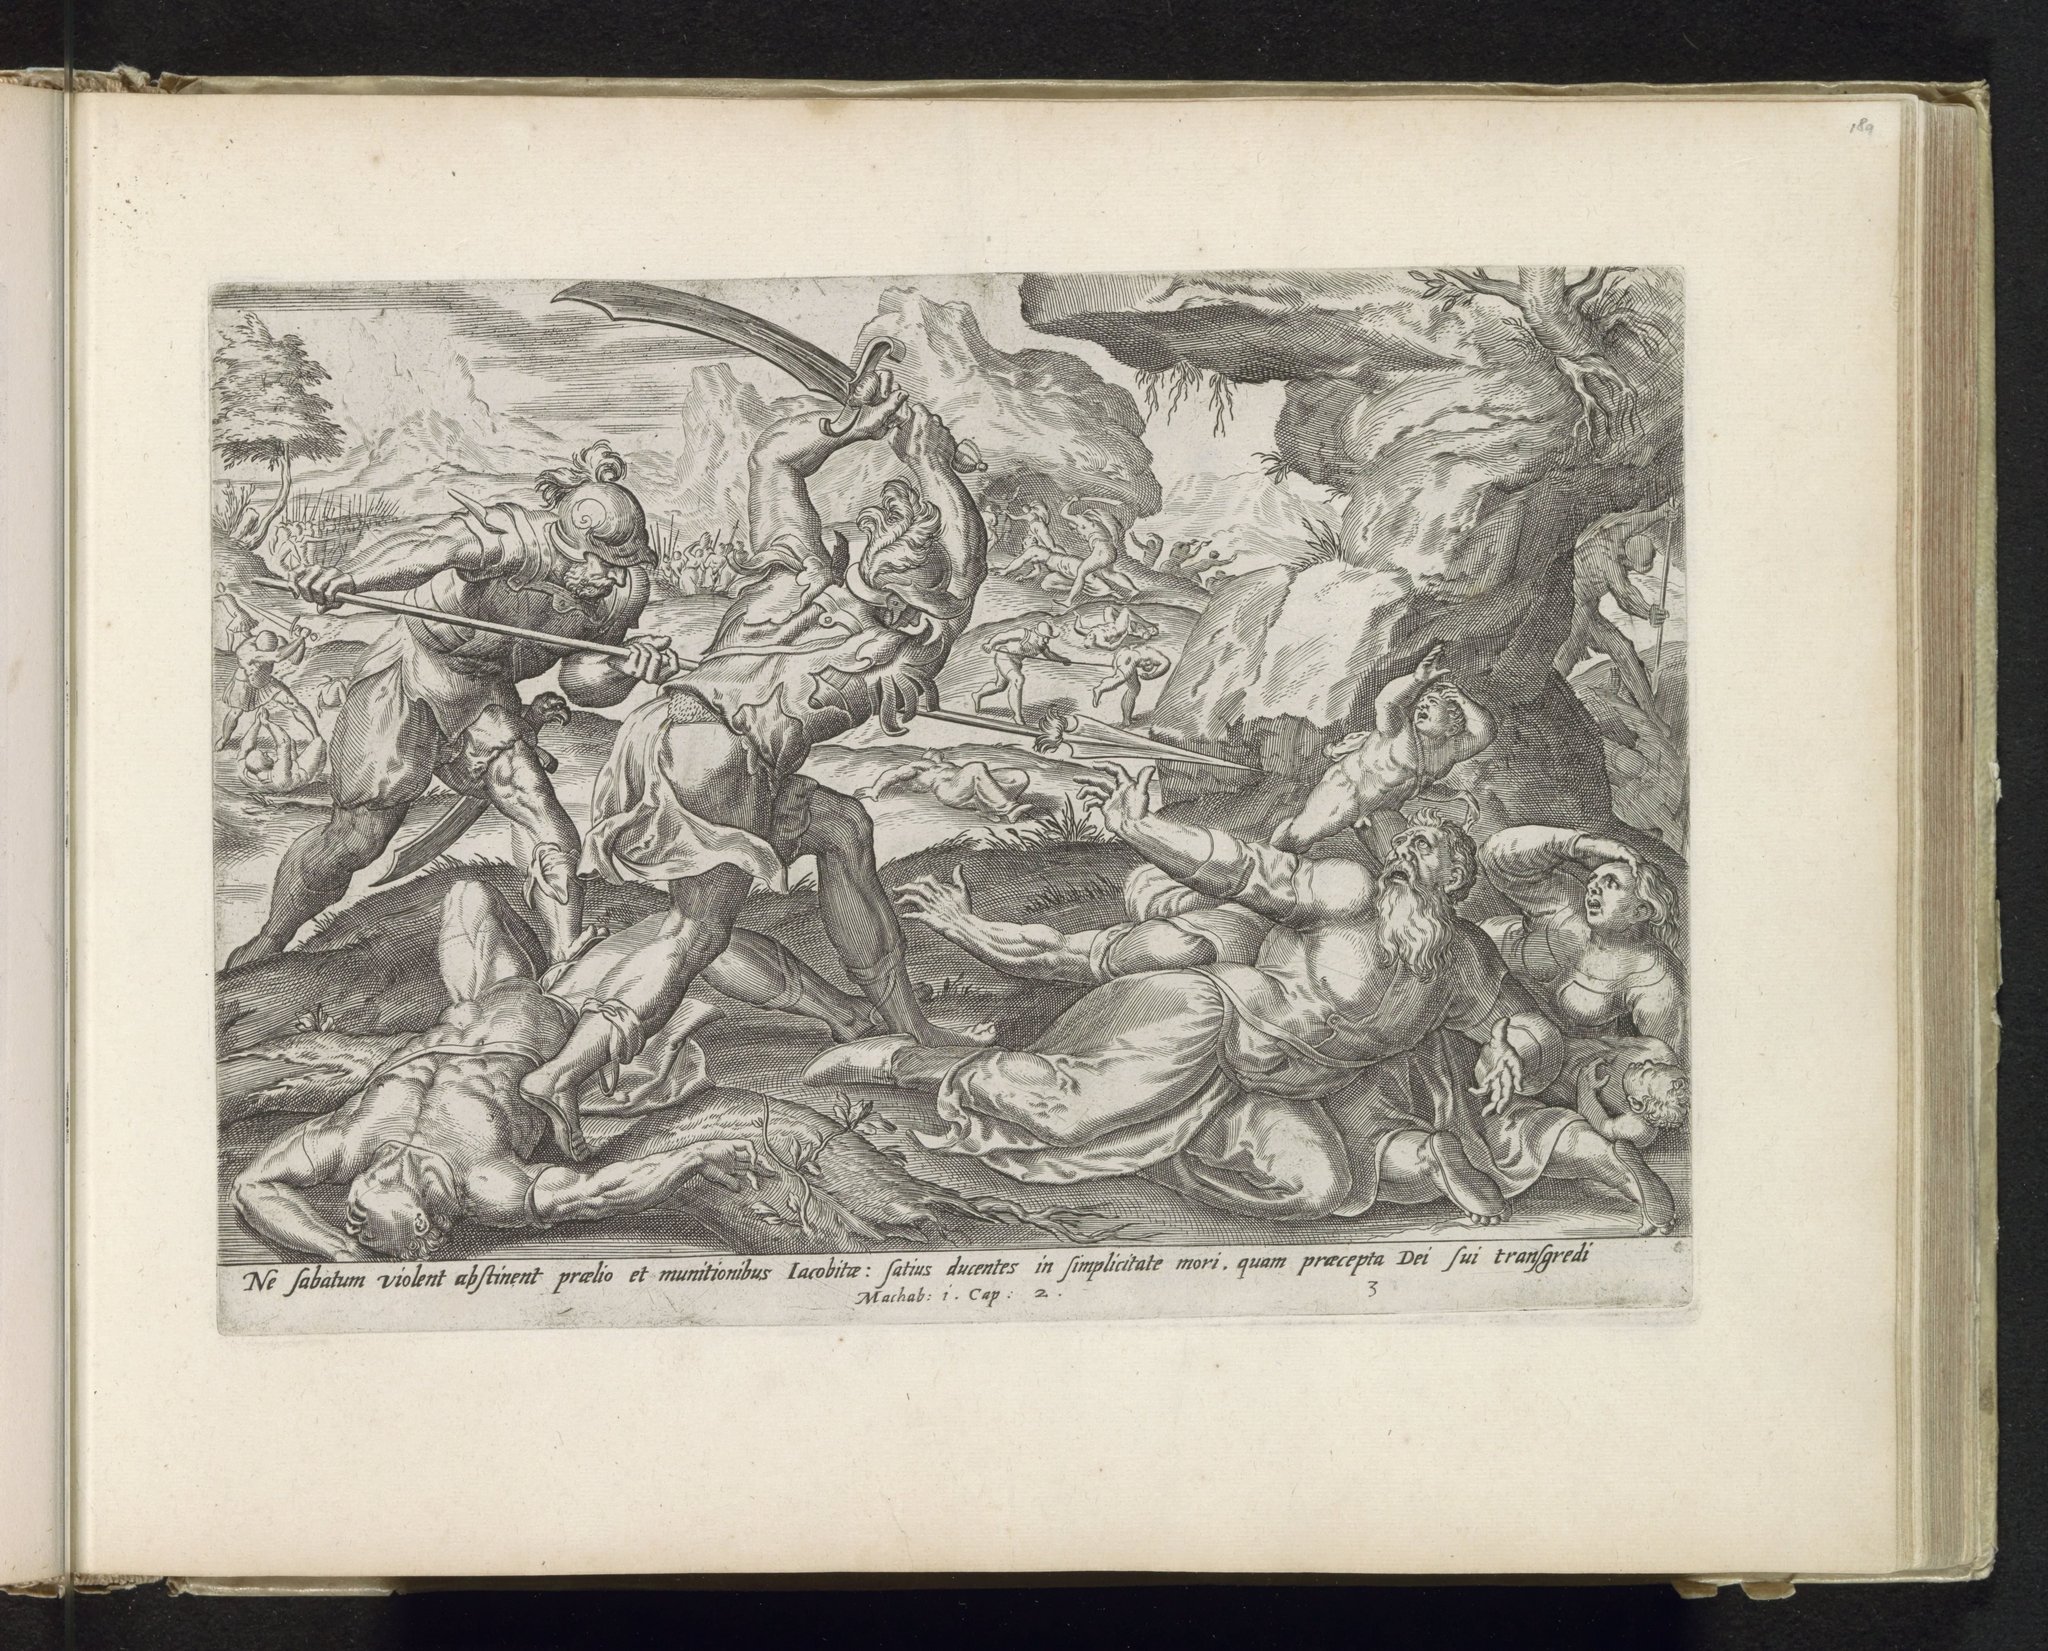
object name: print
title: Leger van Antiochus Epifanes doodt Israëlieten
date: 1585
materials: paper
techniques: engraving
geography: antwerp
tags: the jews without resistance slain on the sabbath (1 maccabees 2:31-38)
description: Israëlieten die het gebod van Antiochus Epifanes hadden genegeerd worden op sabbat aangevallen en afgeslacht door het leger van de koning. Onder de voorstelling een verwijzing in het Latijn naar de Bijbeltekst in 1 Makk. 2. Deze prent maakt deel uit van een album.